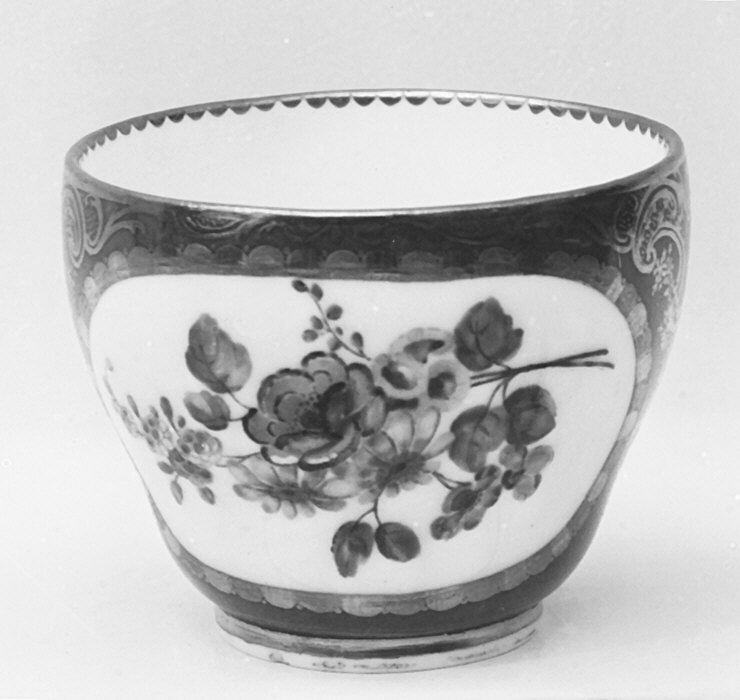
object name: cup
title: Cup (part of a service)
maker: sèvres manufactory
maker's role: manufactory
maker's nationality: french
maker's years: 1740-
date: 1759-1760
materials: soft paste porcelain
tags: flowers